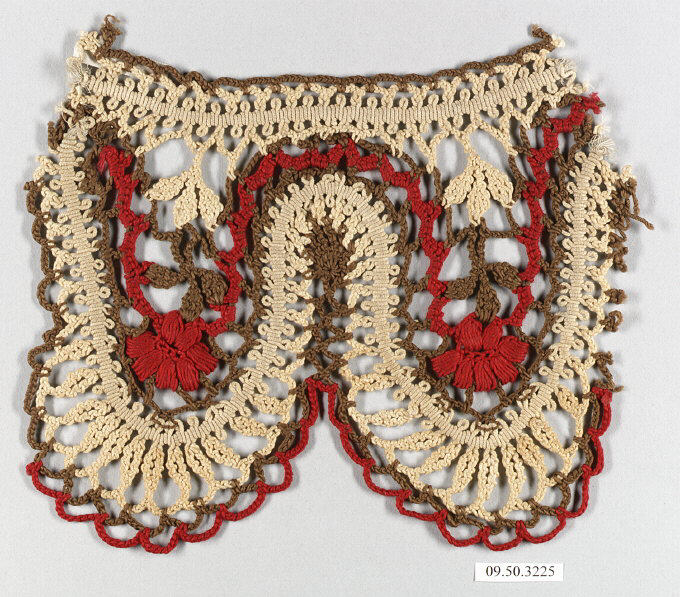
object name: sample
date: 1801-1900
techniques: crochet